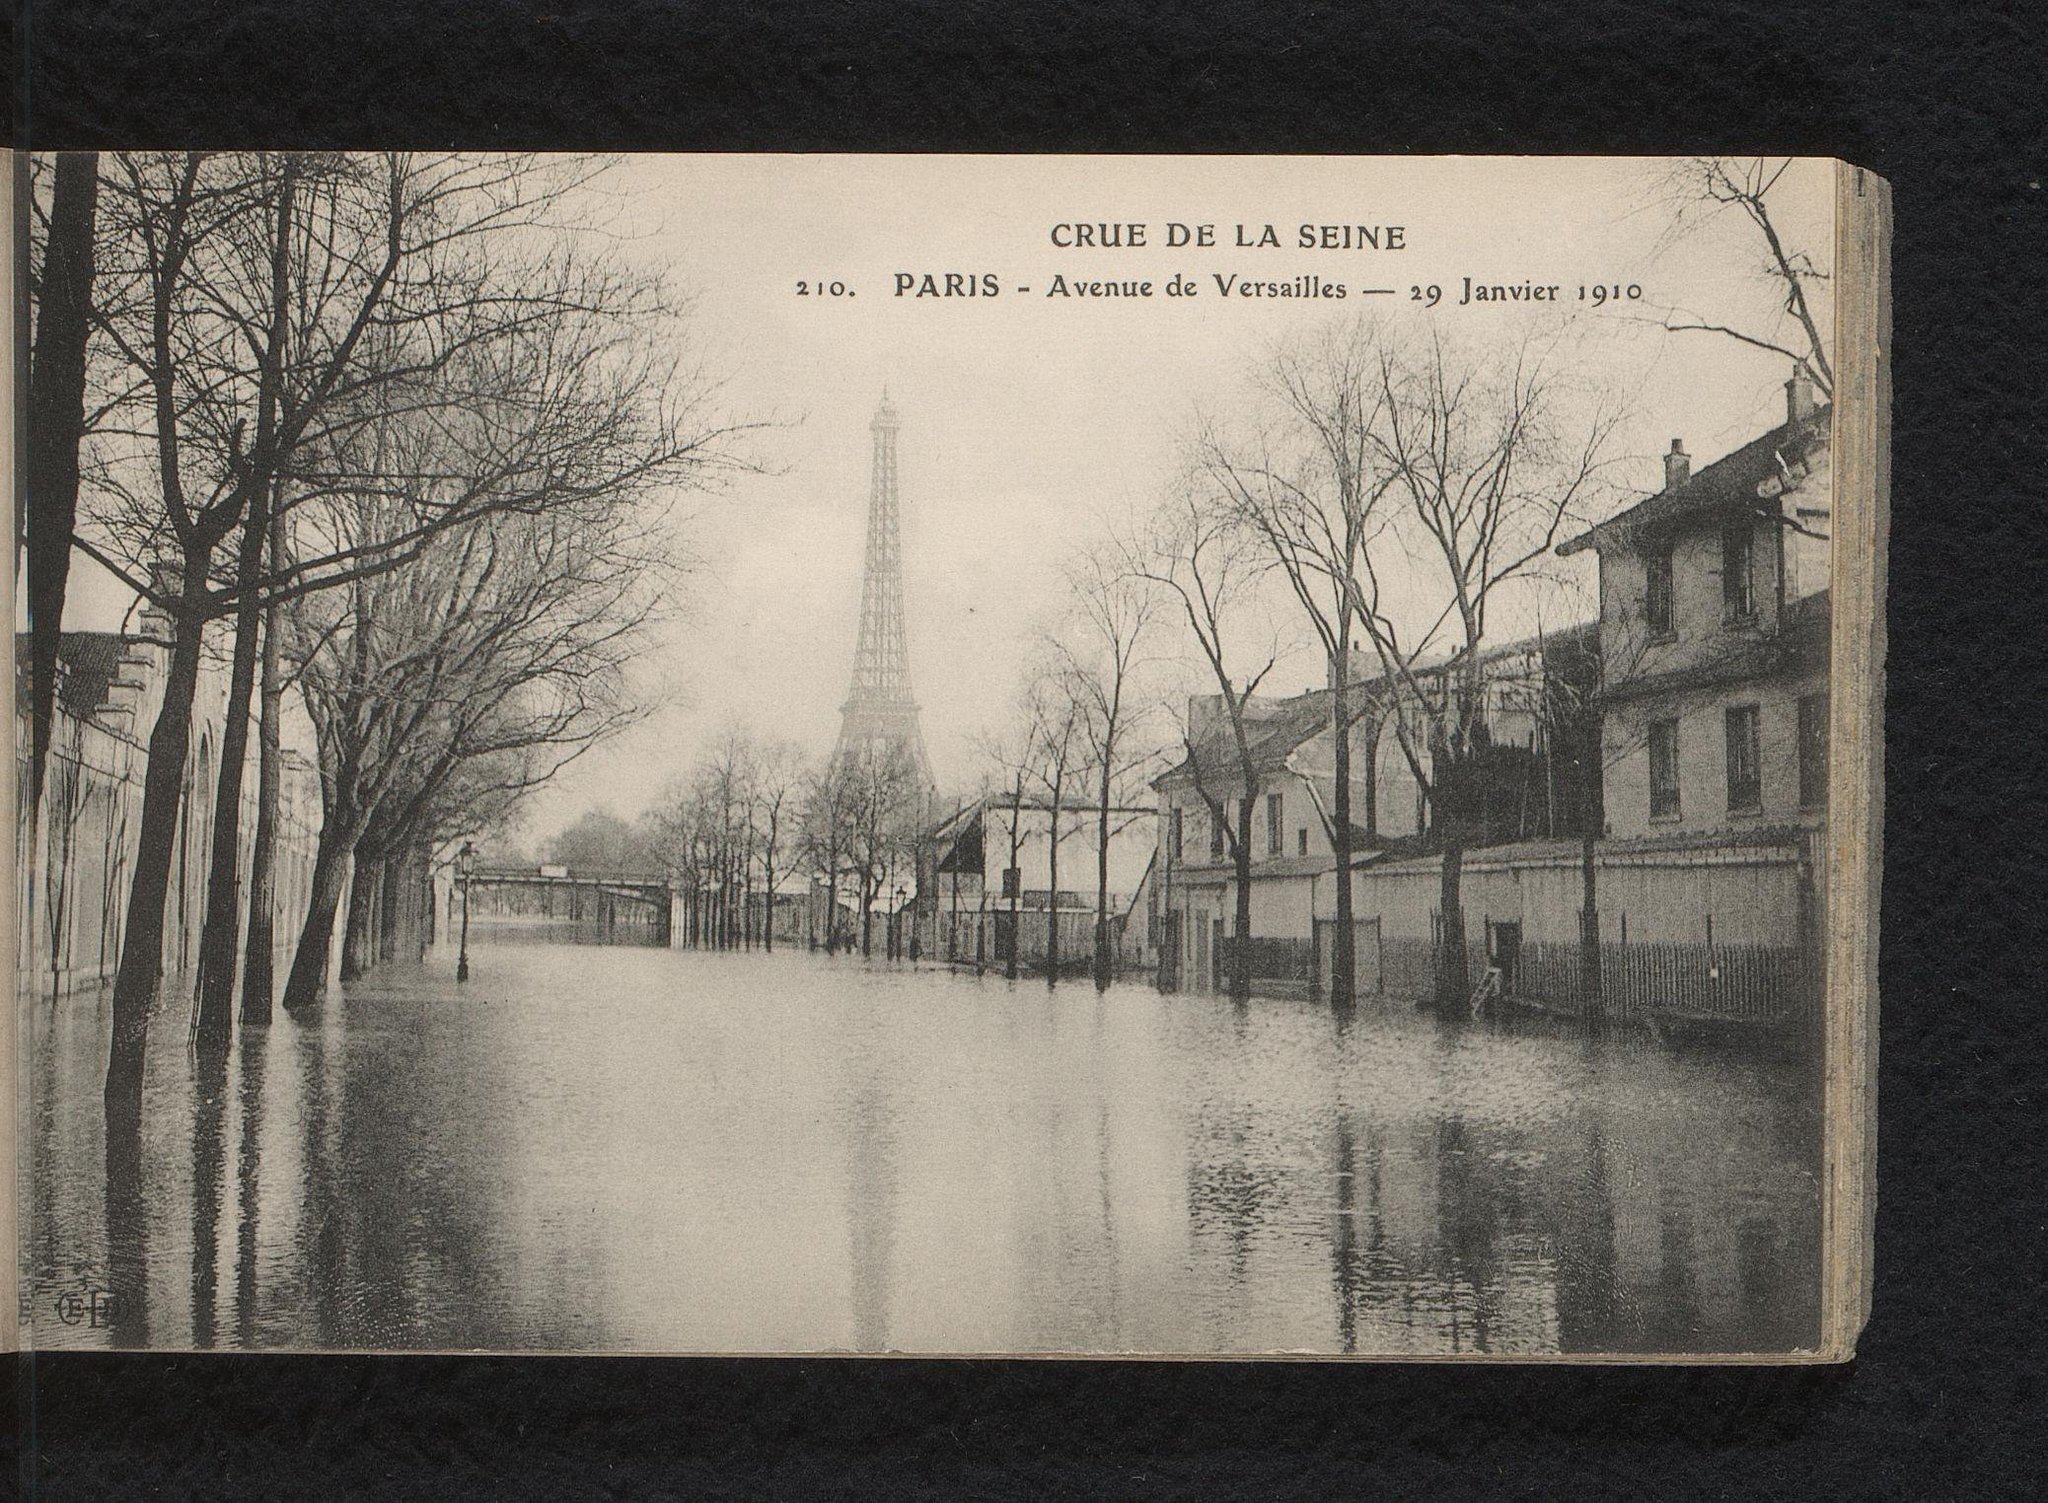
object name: photomechanical print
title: Crue de la Seine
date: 1910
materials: cardboard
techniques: photograph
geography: paris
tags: tower, clock tower ~ monumental adornment, avenue, boulevard, promenade, esplanade (+ city(-scape) with figures, staffage), flood, paris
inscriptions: date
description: Prentbriefkaart maakt deel uit van een album.